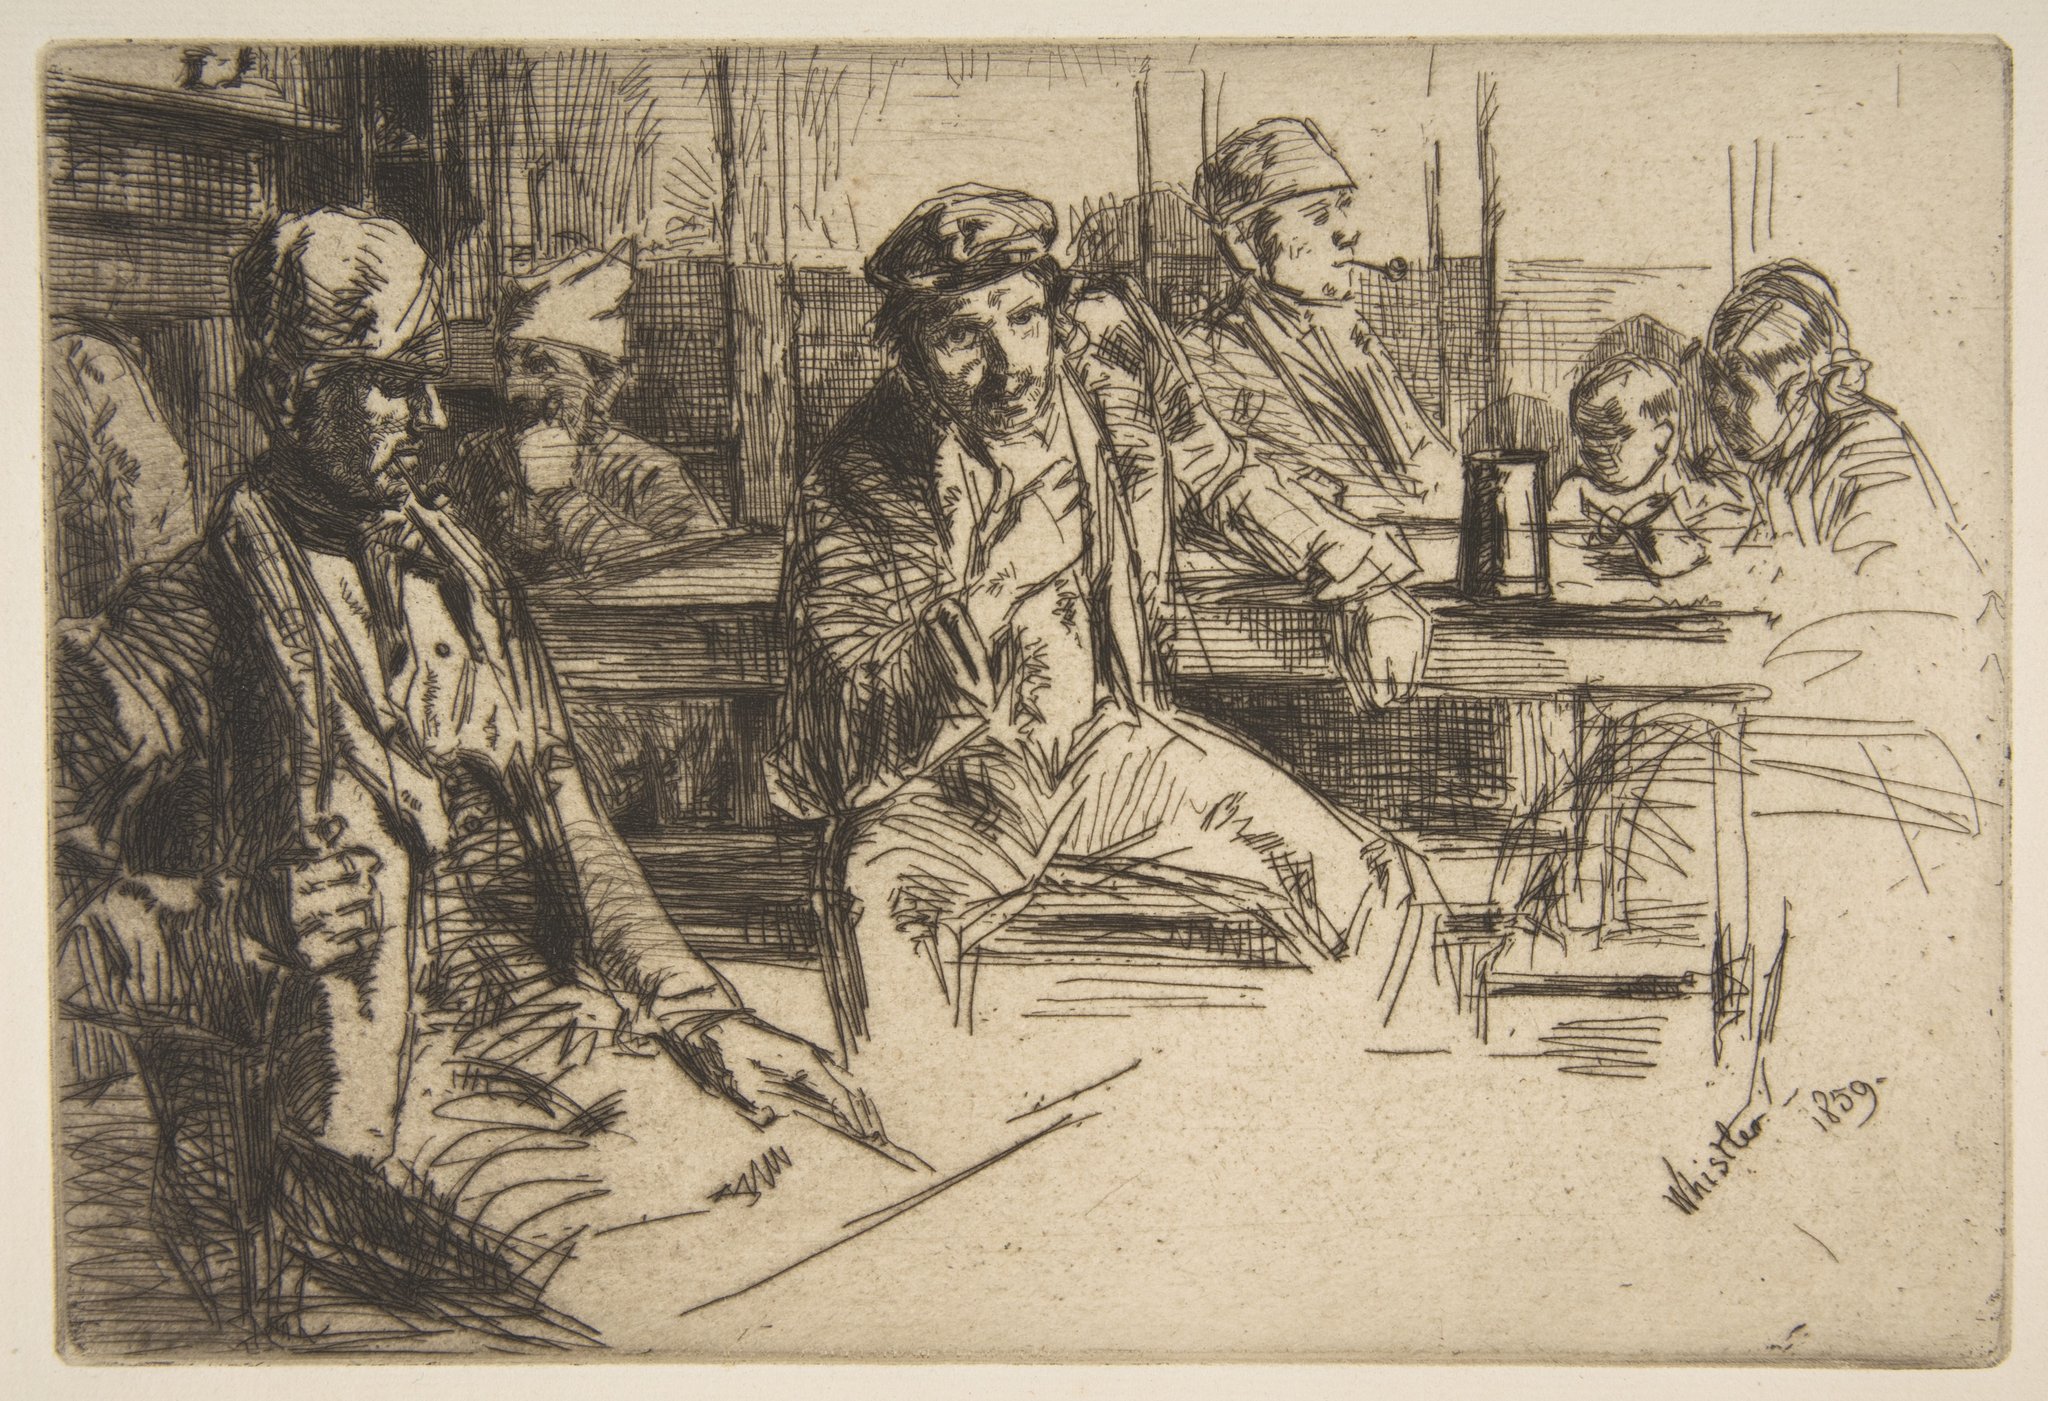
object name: print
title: Longshore Men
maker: james mcneill whistler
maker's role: artist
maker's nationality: american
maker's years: 1834-1903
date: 1859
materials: ink, paper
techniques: drypoint, etching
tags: men,smoking